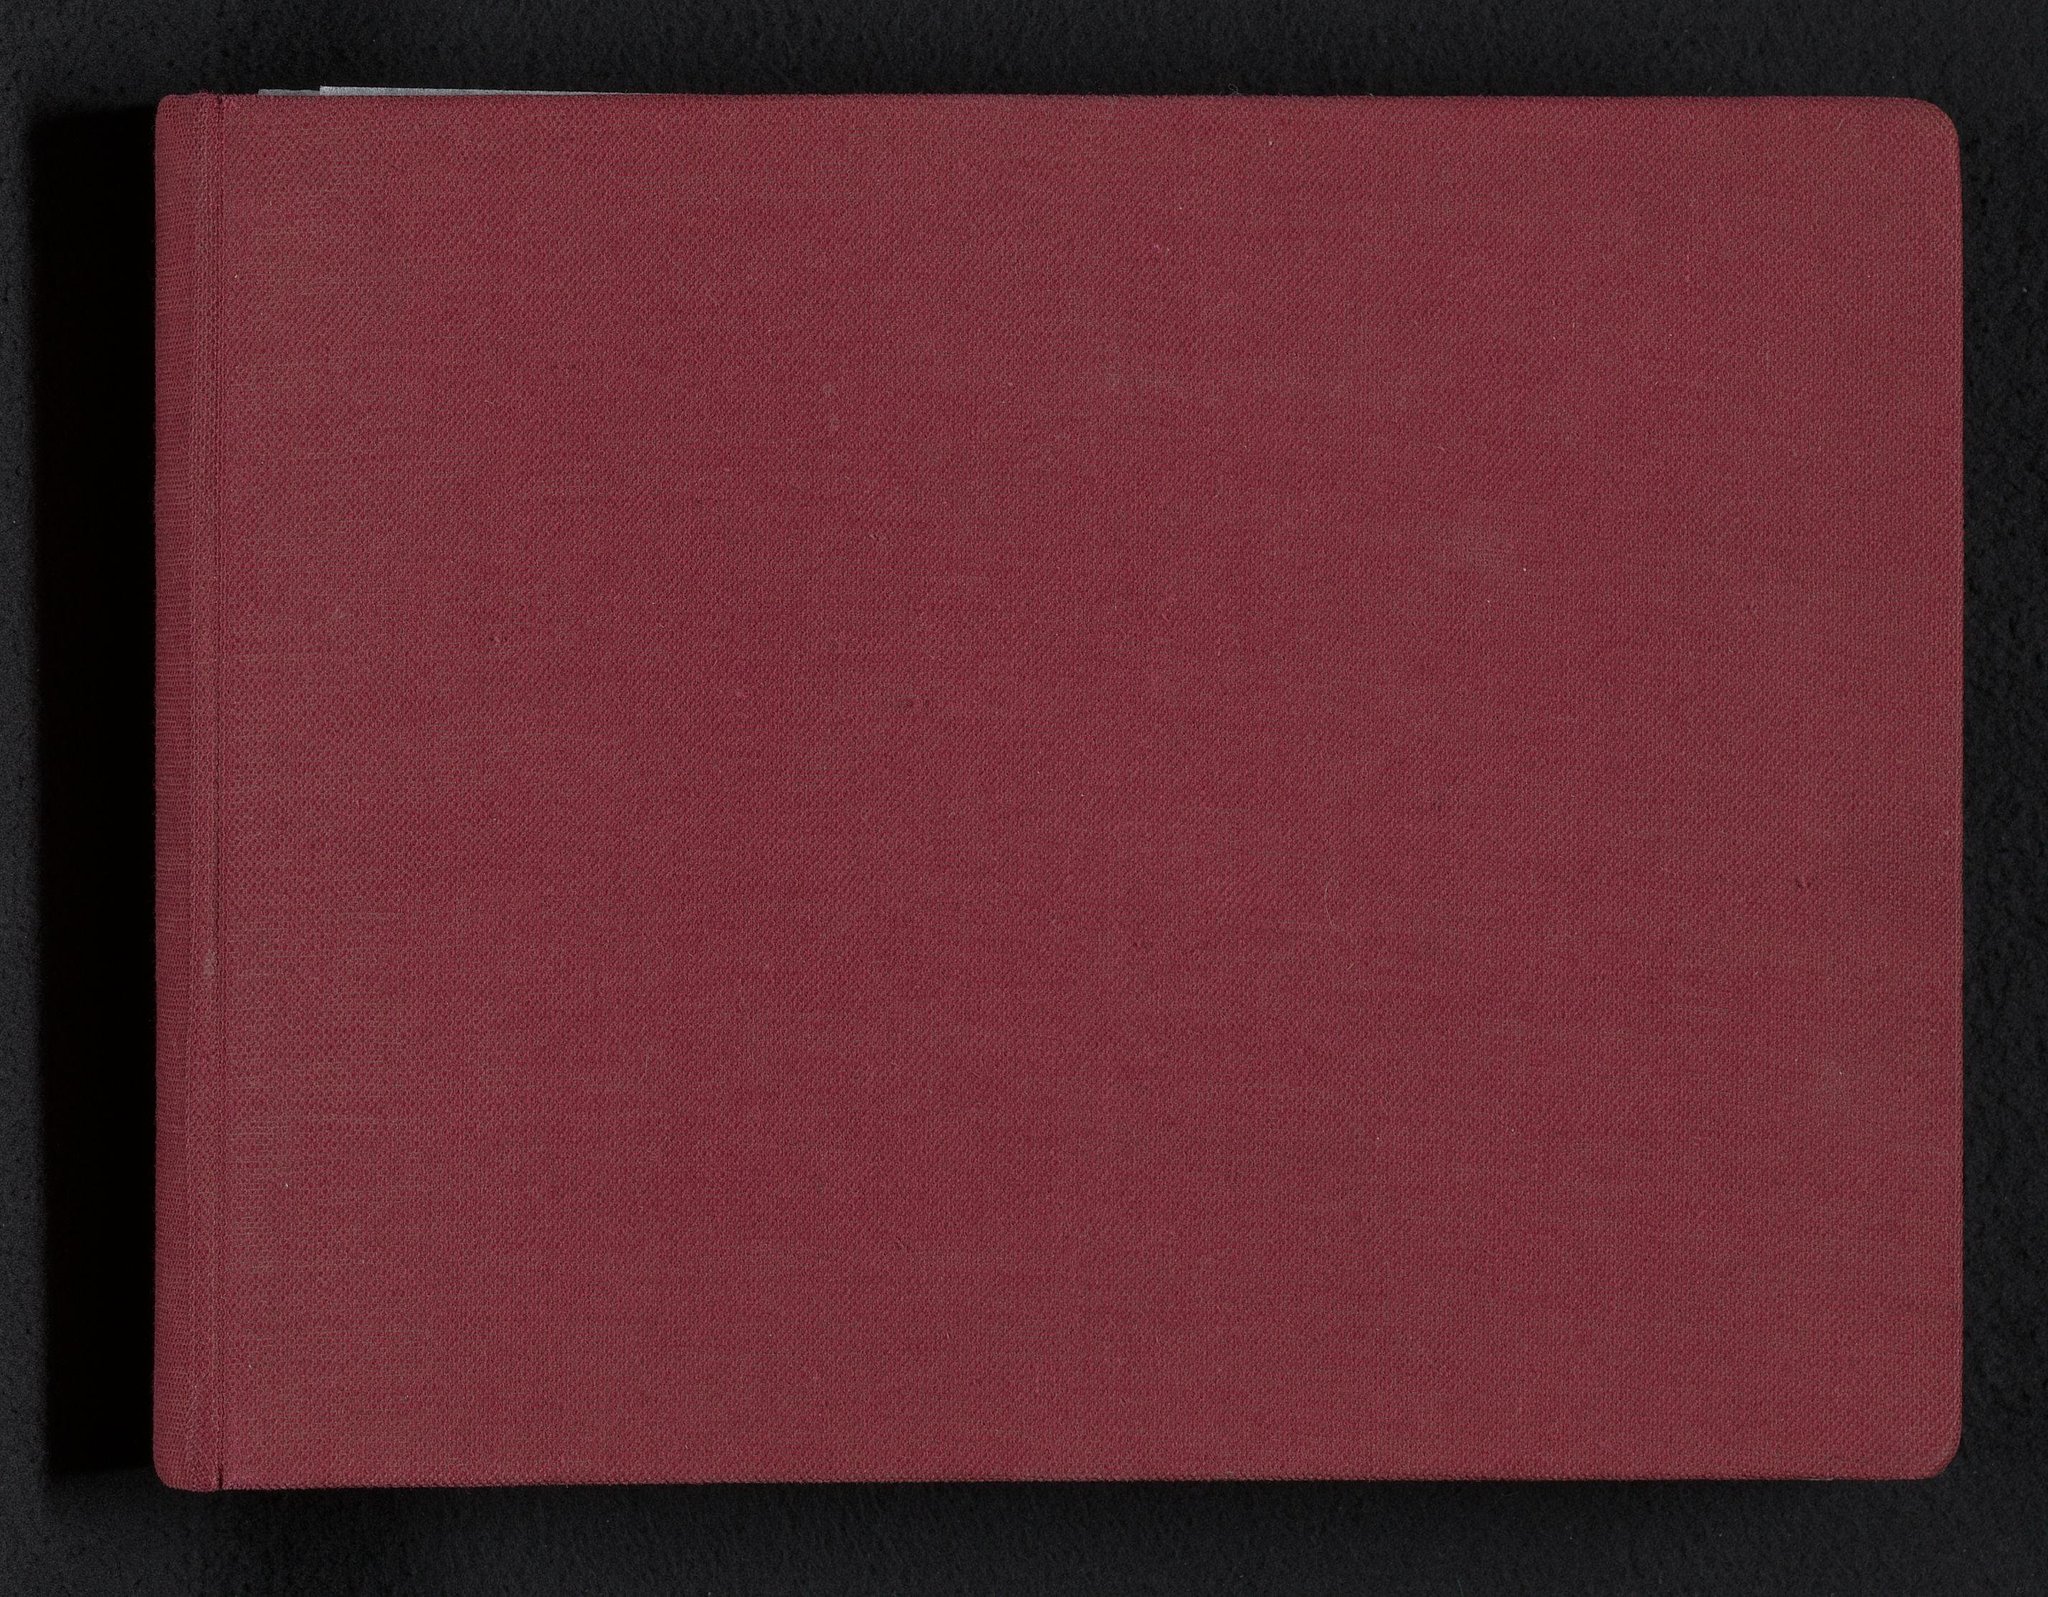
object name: tekeningenalbum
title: Album met vijftig gezichten van parken in Wiesbaden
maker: carel nicolaas storm van s-gravesande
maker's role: draughtsman, print maker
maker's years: 1841-1924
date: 1915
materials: chalk, linen, paper, pencil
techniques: bookbinding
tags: flowers, park, plants and herbs, garden pond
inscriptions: collector's mark: Lugt 2228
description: Album met een titelpagina en 50 krijttekeningen op 50 albumbladen bevattende parken, bomen, vijvers, bloemen en fonteinen in Wiesbaden, met name in en rondom het Kurpark en Slot Biebrich.